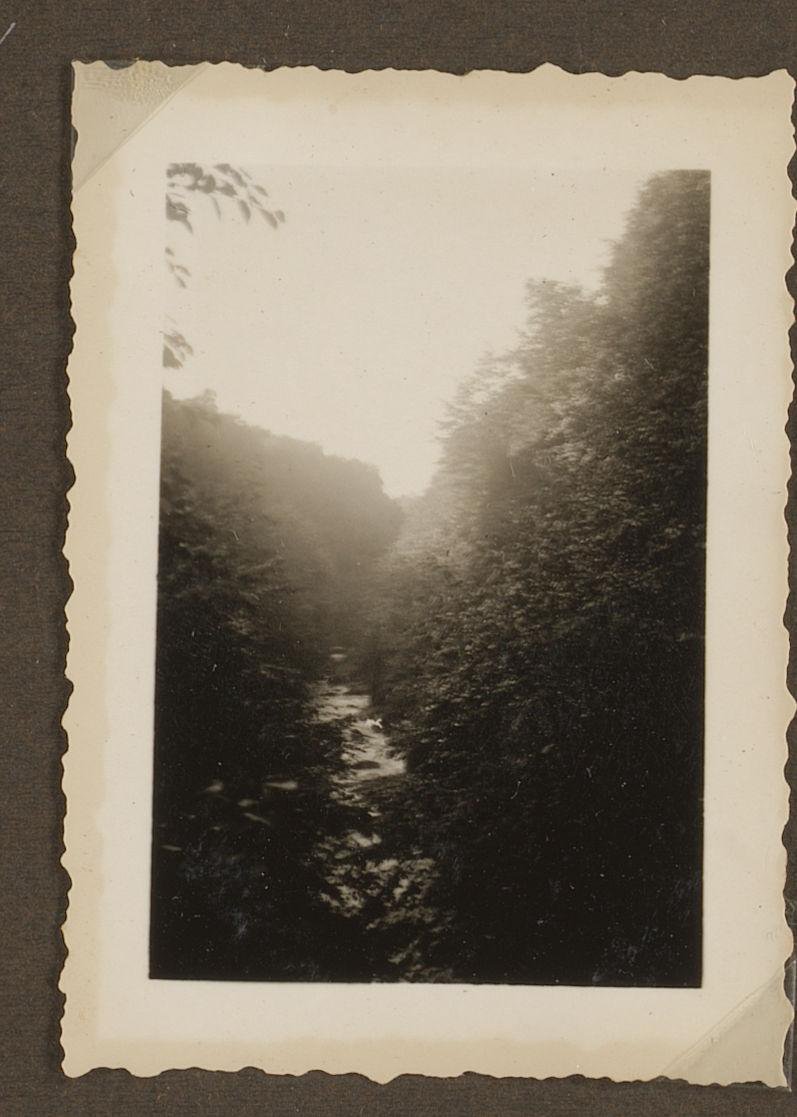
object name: album leaf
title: Gezicht op de rivier de Cassarate nabij Lugano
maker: Anonymous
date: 1934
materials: paper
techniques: gelatin silver print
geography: lugano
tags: river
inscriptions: number: ‘26’